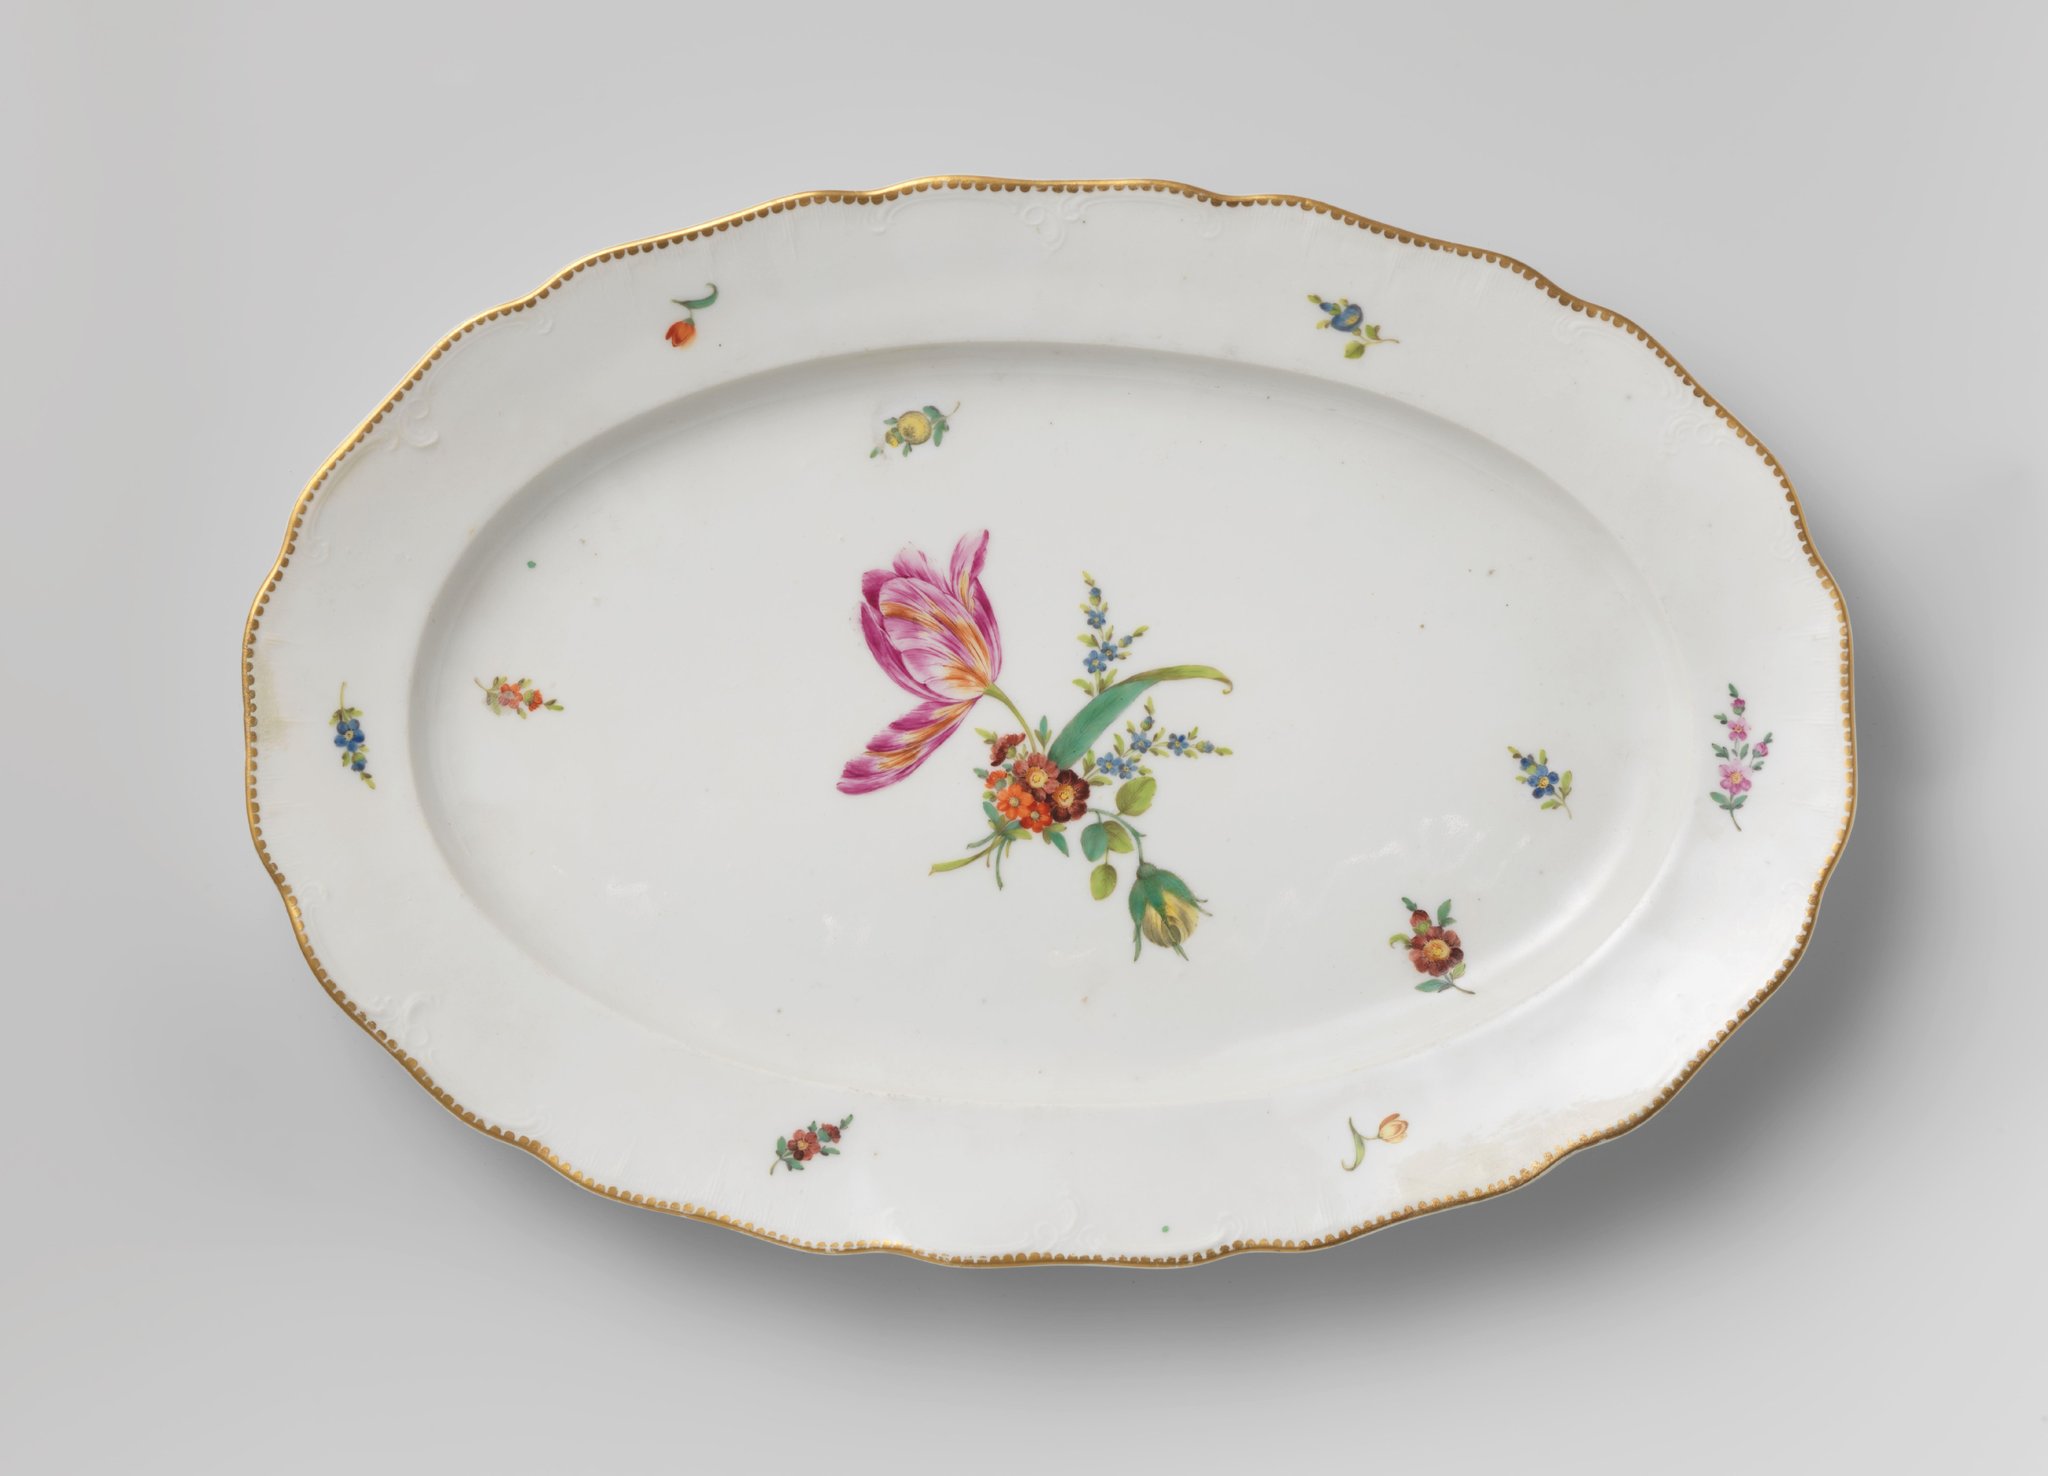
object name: soup tureen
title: Schotel van porselein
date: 1774-1784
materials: porcelain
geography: loosdrecht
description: Onderschotel van porselein. Beschilderd met boeketten en strooibloemen.